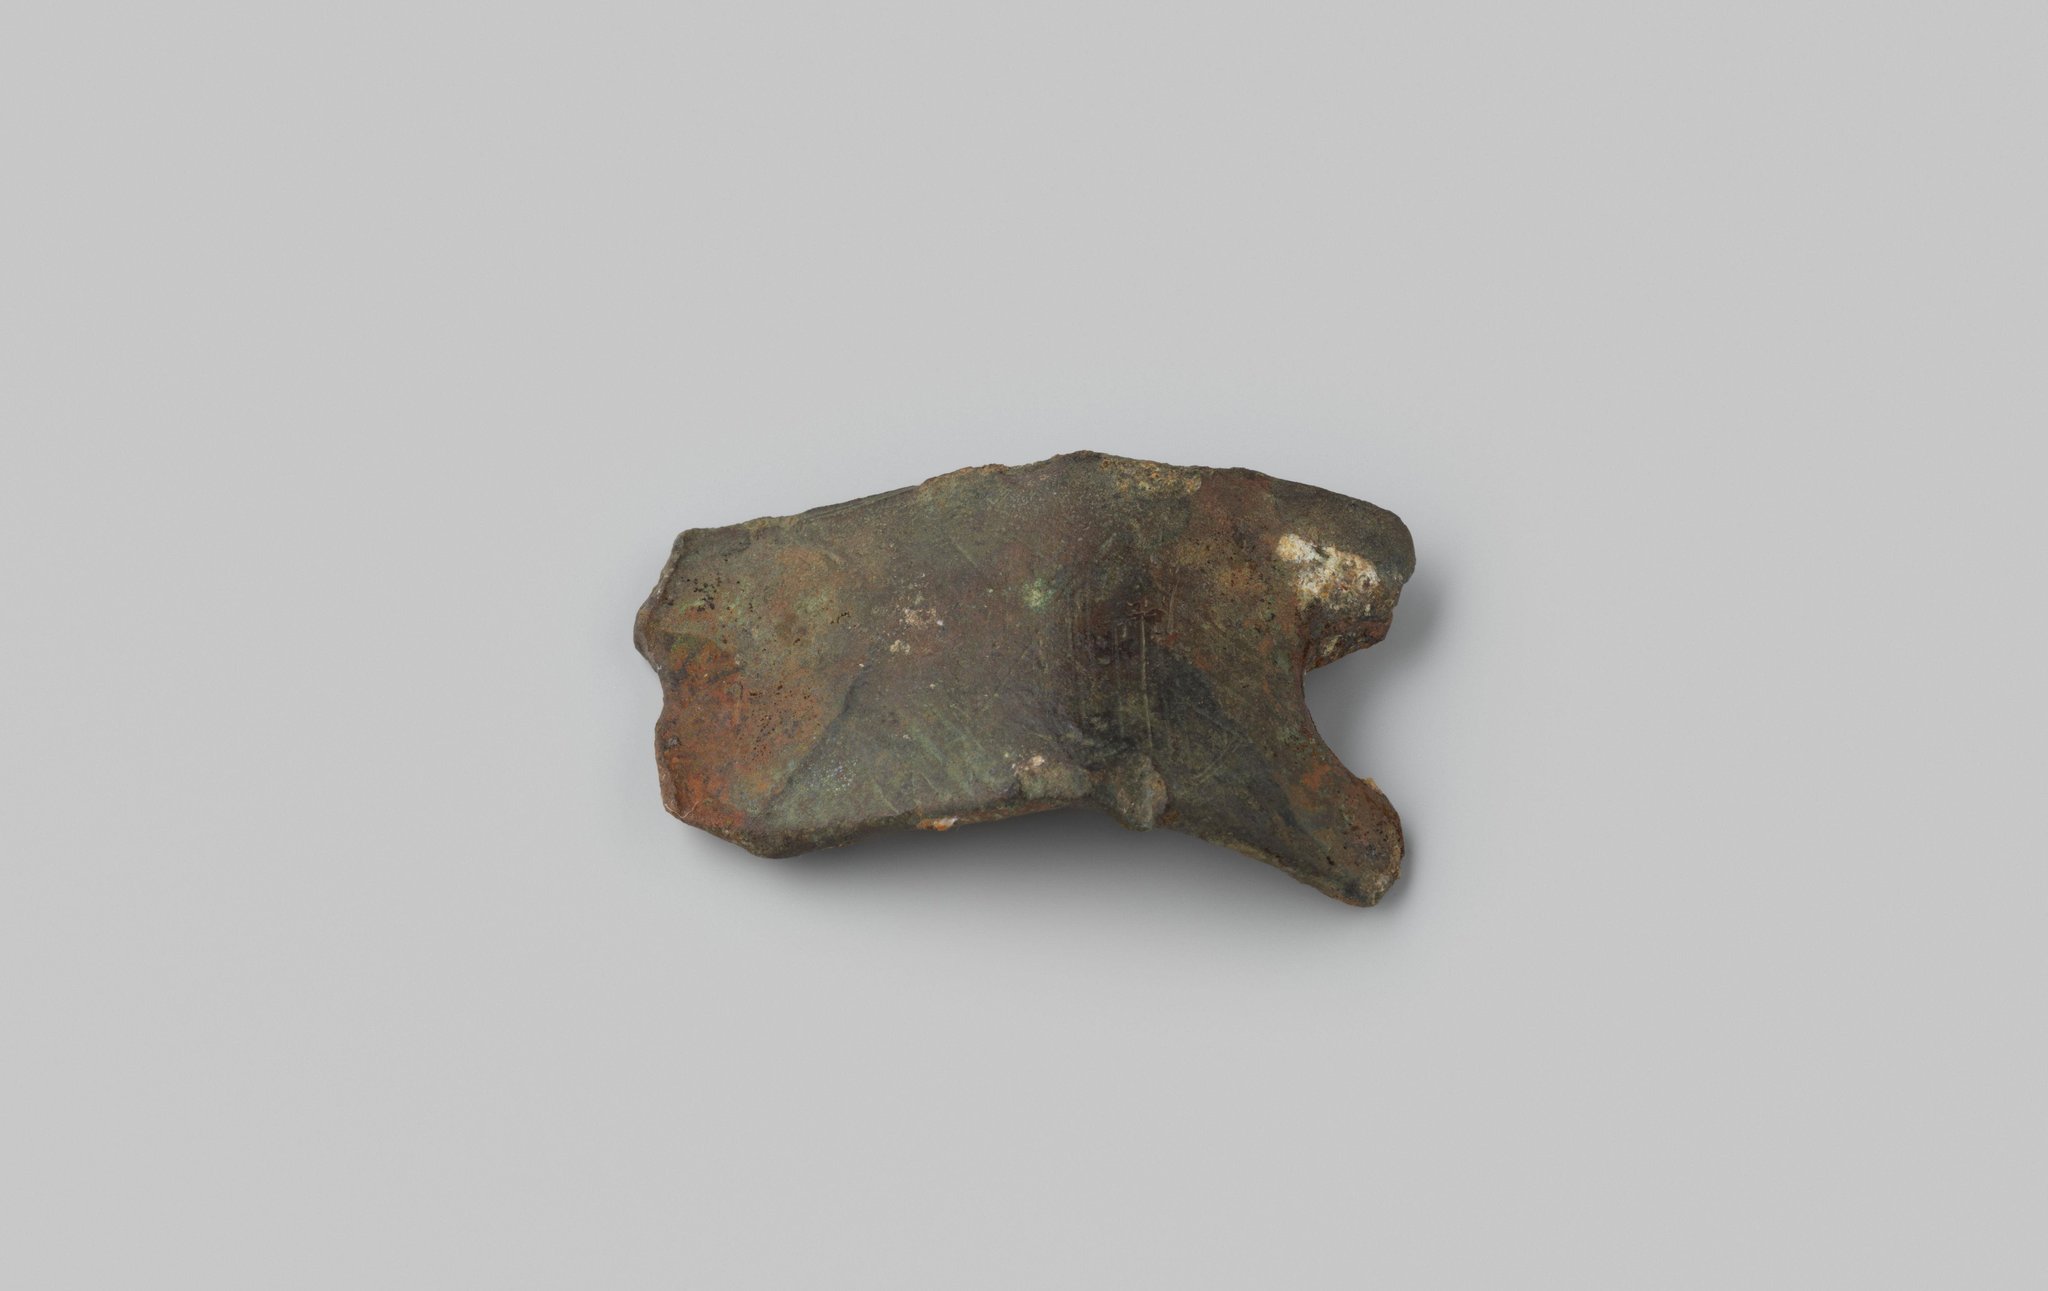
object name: part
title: Onderdeel of hulpstuk afkomstig uit het wrak van de Oost-Indiëvaarder Hollandia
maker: Anonymous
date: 1700-1743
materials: copper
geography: netherlands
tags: verenigde oostindische compagnie, hollandia (schip)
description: Strip-shaped fitting; fragm, squashed, sim. 80H1737, both ends broken, remains of 1 hole.